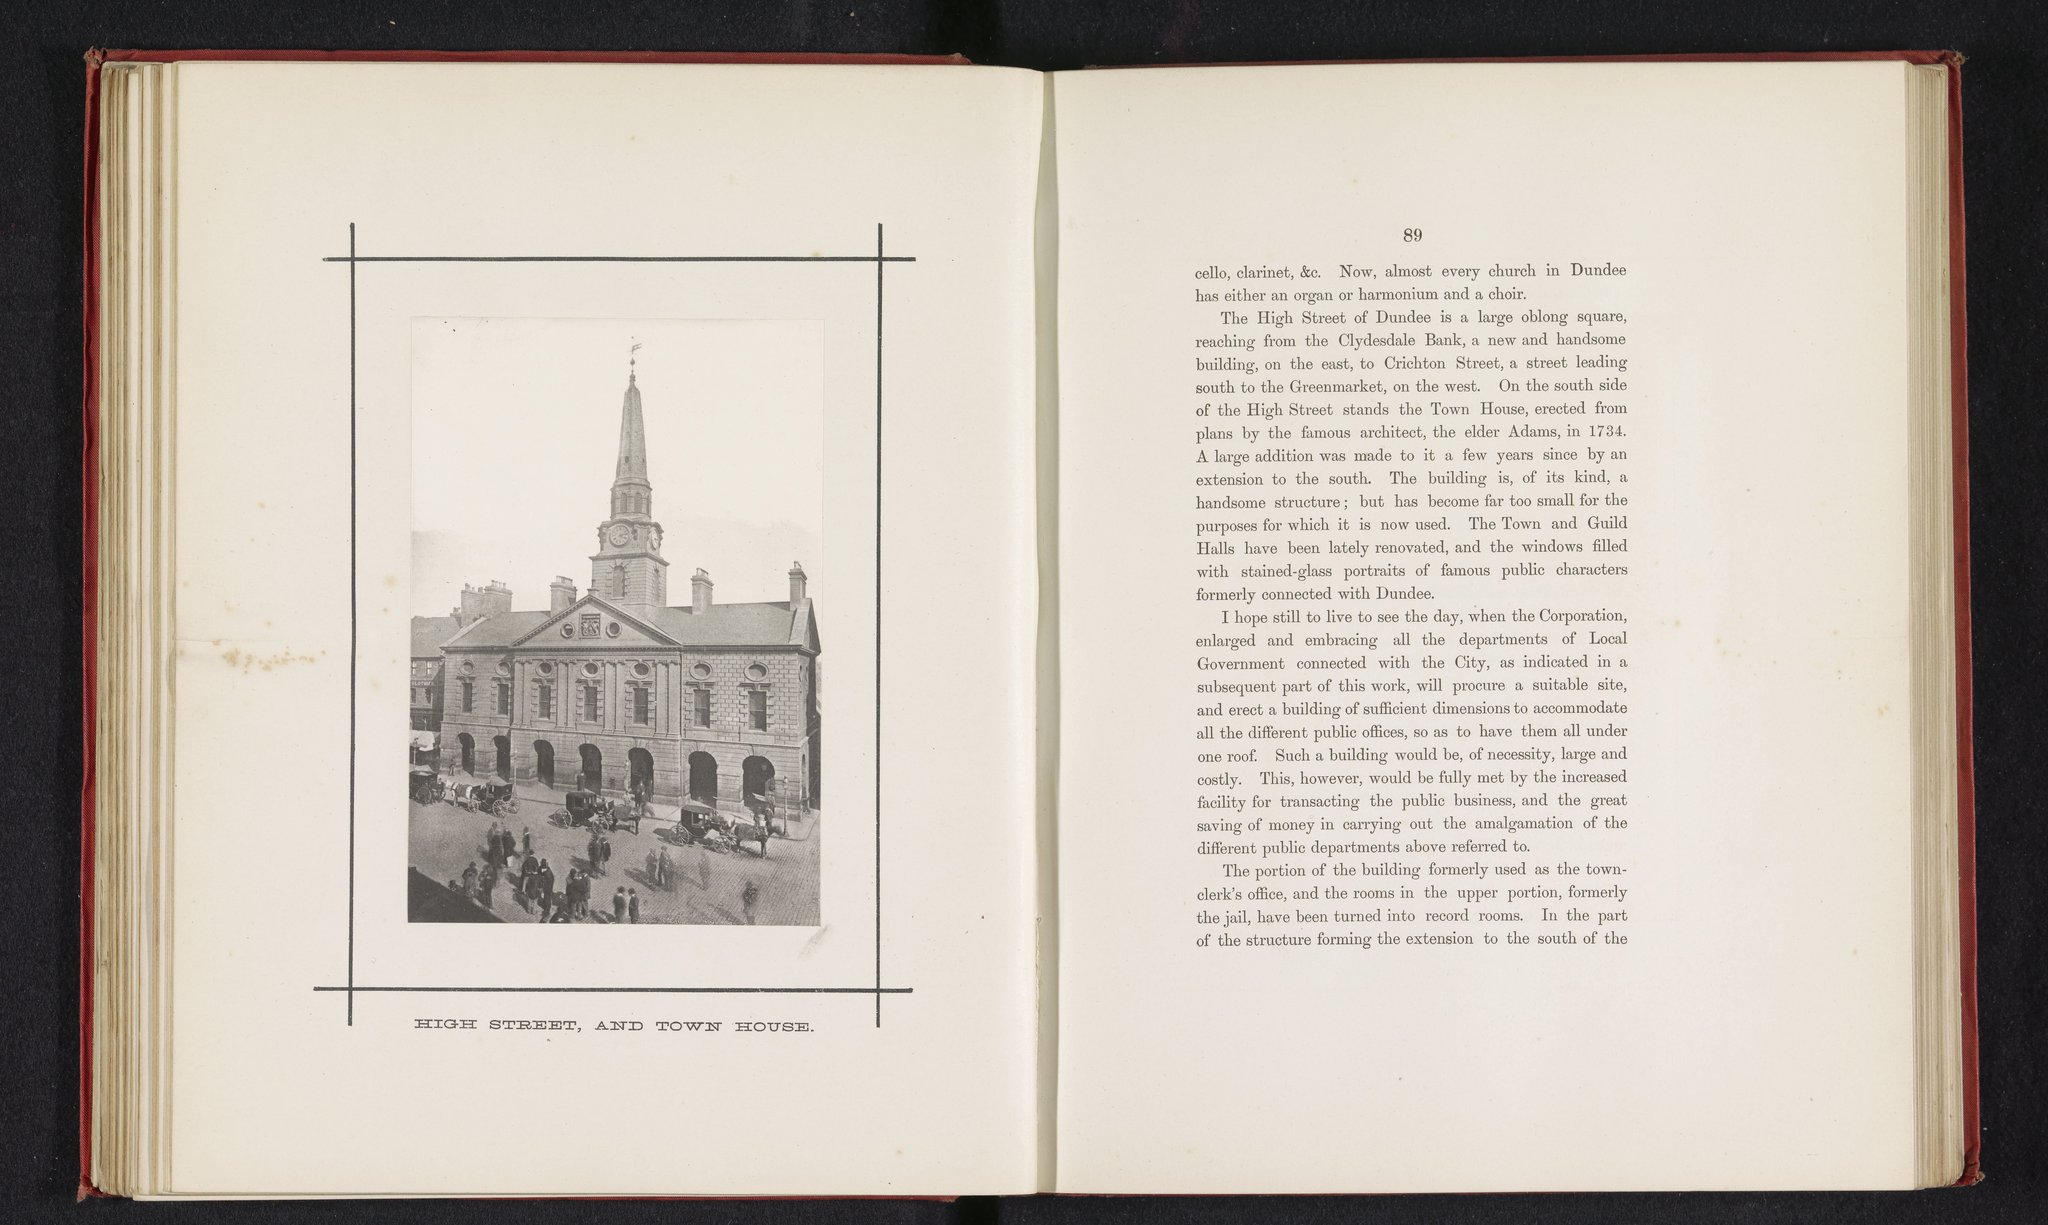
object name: photograph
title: HIGH STREET, AND TOWN HOUSE.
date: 1880-1890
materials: photographic support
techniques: platinum process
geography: dundee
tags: townhall, exterior ~ representation of a building, street (+ city(-scape) with figures, staffage)